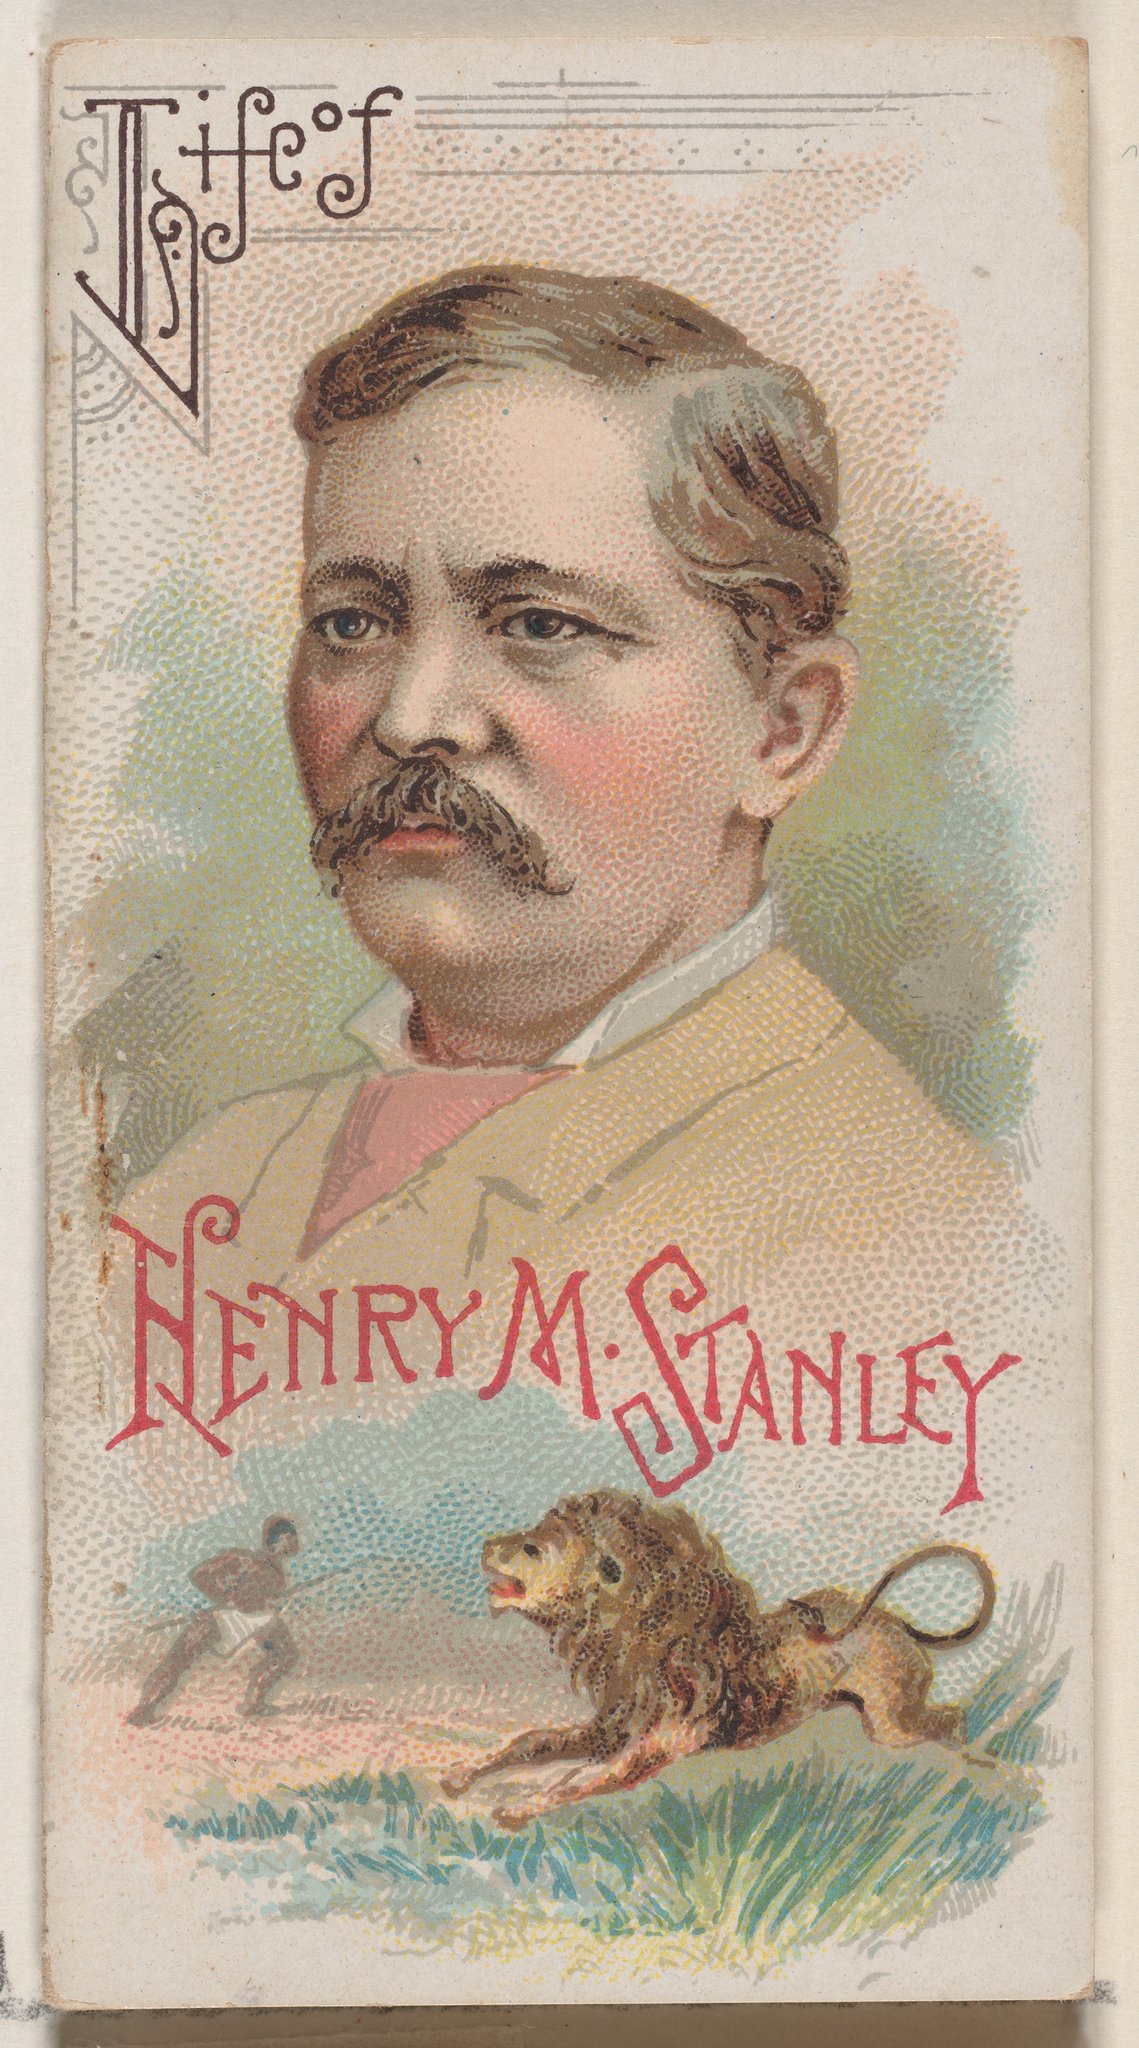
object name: print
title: Life of Henry M. Stanley, from the Histories of Poor Boys and Famous People series of booklets (N79) for Duke brand cigarettes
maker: w. duke, sons & co.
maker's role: publisher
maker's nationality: american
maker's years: 1870-1920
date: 1888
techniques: color lithograph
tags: men,portraits